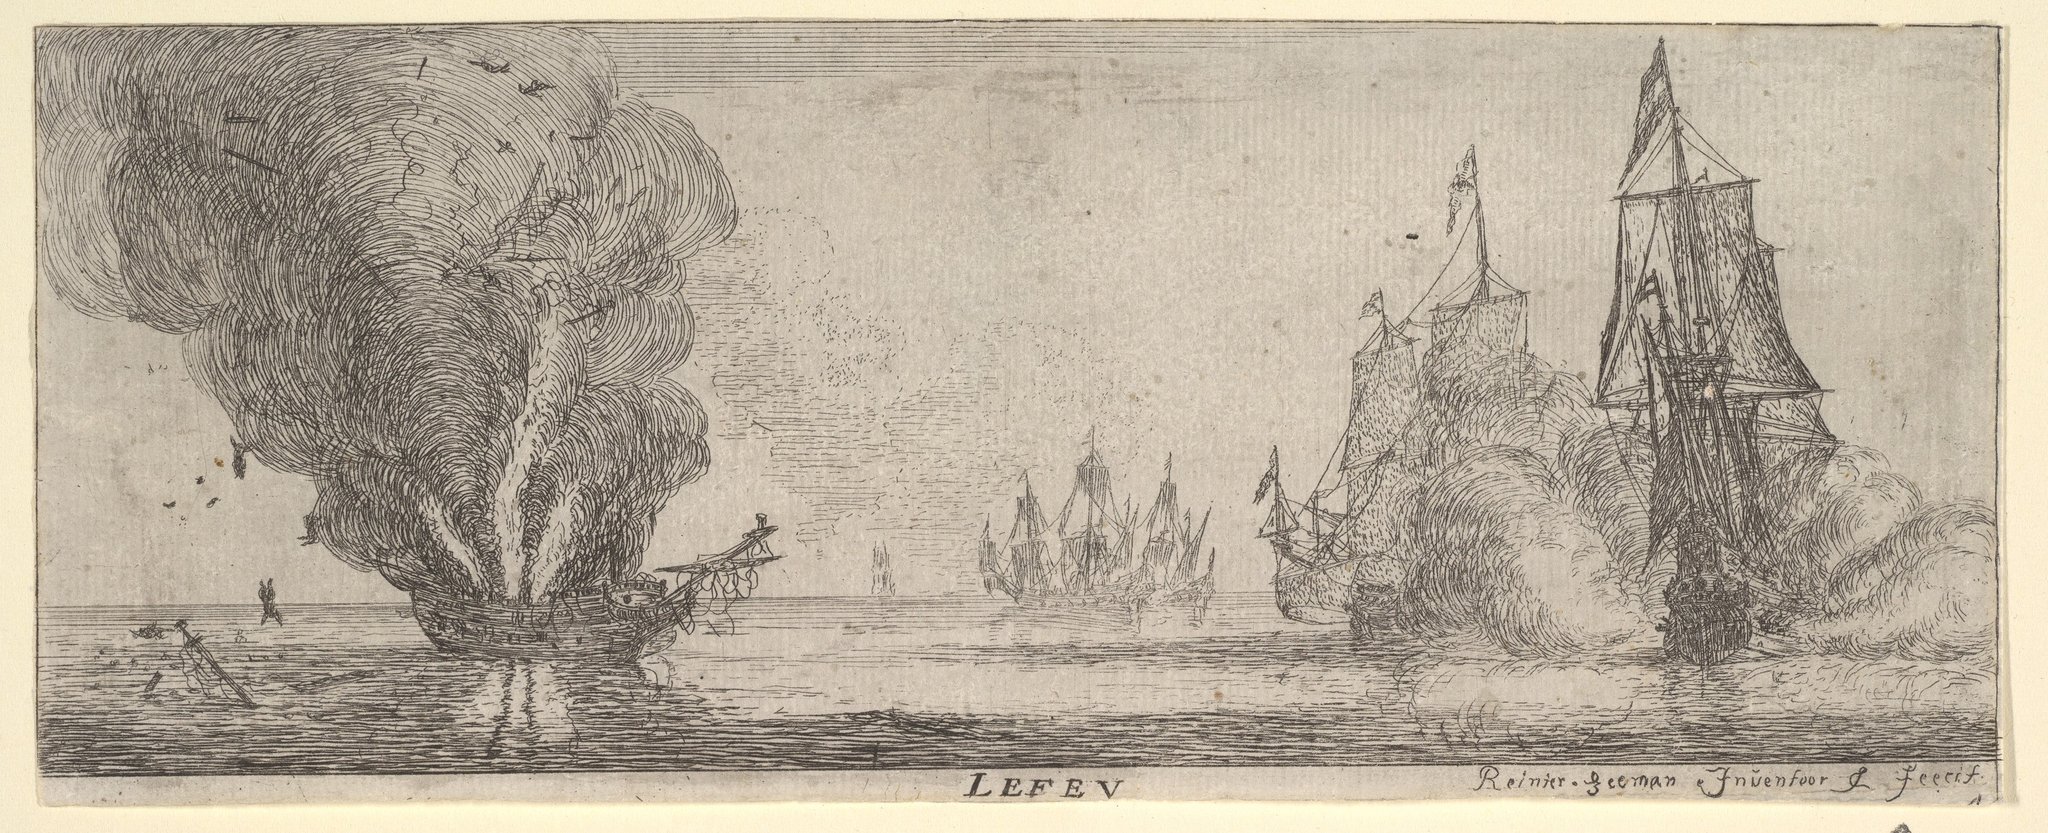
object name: print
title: Le Feu, from The Elements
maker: reinier nooms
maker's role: artist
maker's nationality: dutch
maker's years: 1623-1664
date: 1601-1700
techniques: etching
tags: fire,ships